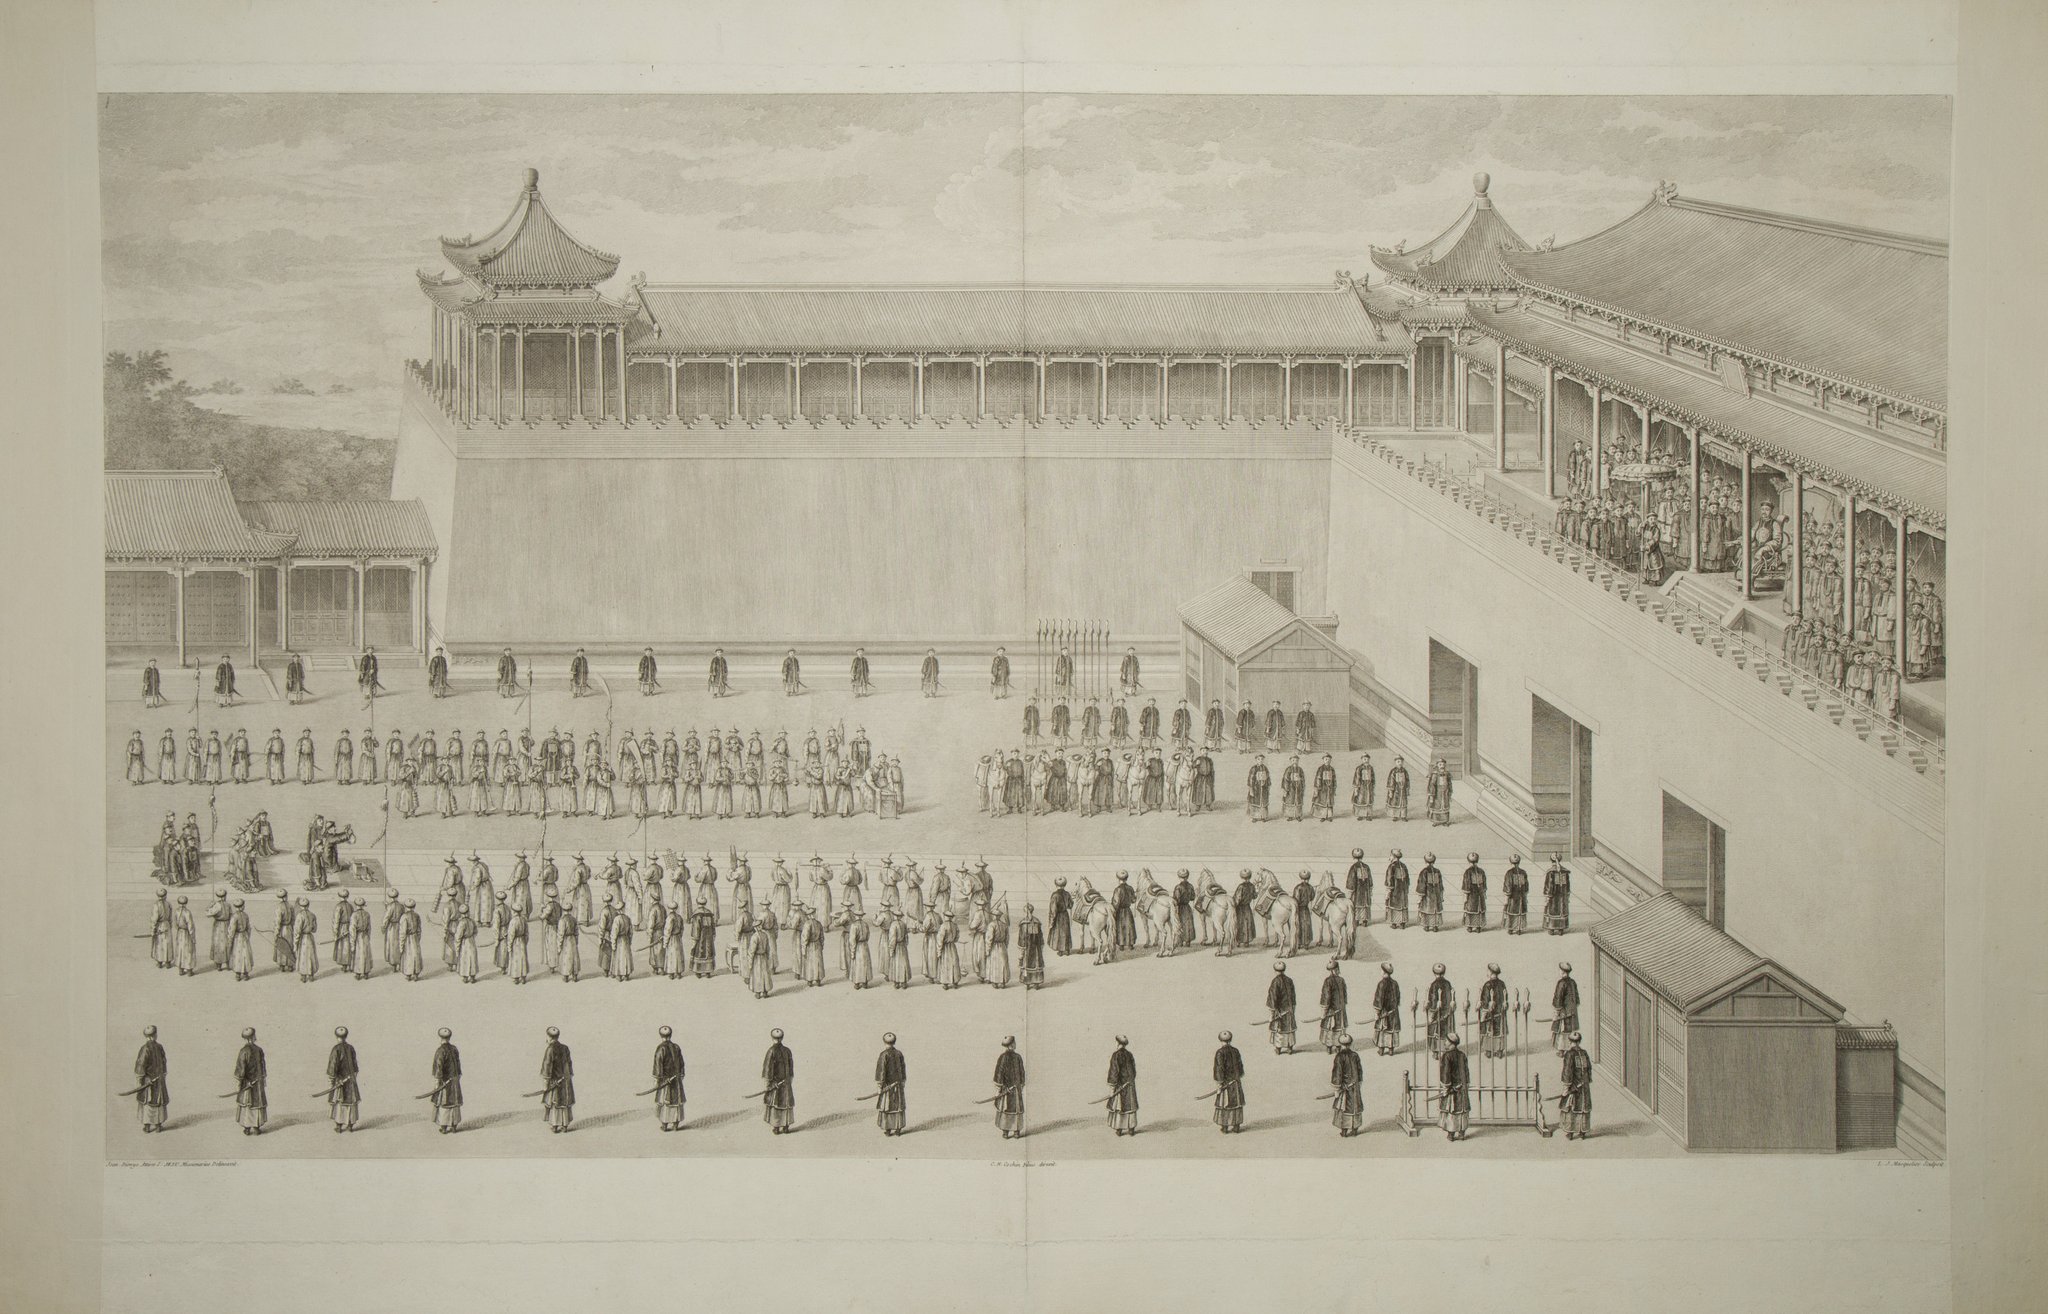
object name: print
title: Prisoners Presented to the Emperor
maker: louis joseph masquelier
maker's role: print maker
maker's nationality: french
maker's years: 1741-1811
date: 1767-1774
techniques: engraving, etching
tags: prisons,prisoners